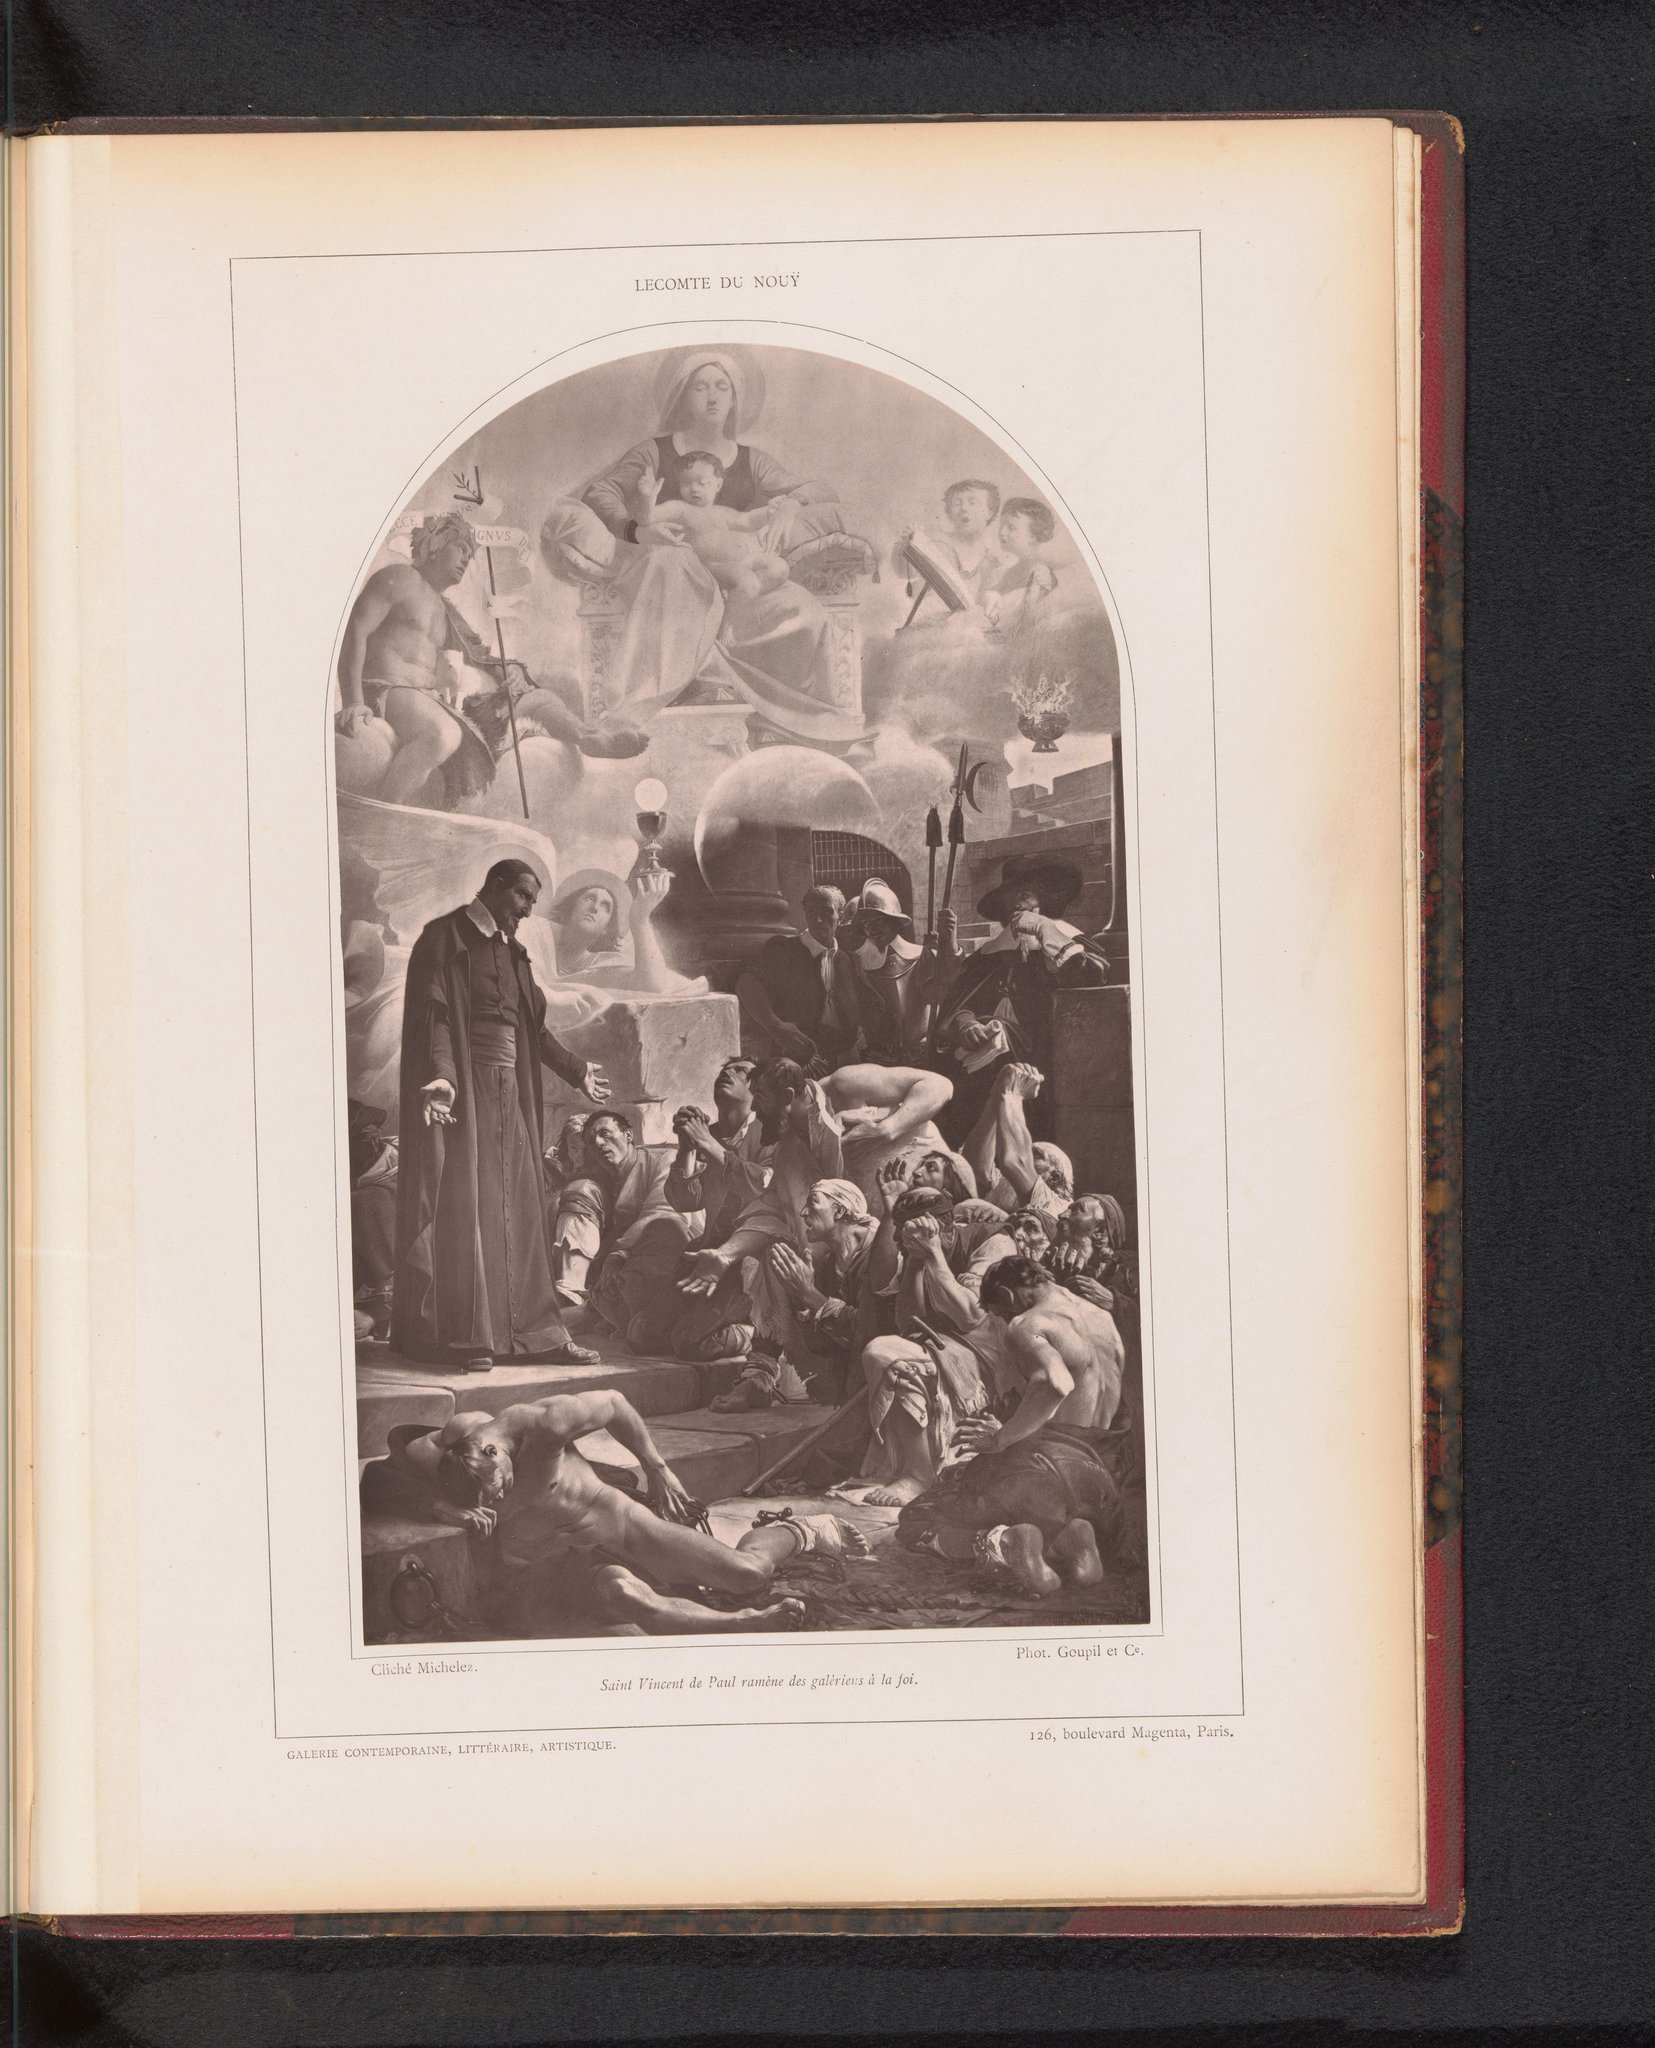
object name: photomechanical print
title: Reproductie van Saint Vincent de Paul remène des galéries à la foi door Jean-Jules-Antoine Lecomte du Noüy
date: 1872-1877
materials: paper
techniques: woodburytype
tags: male saints (with name), painting, drawing and the graphic arts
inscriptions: inscription: ‘Lecomte du Nouy/ Galerie Contemporaine, Littéraire, Artistque/ 126, boulevard Magenta, Paris.’